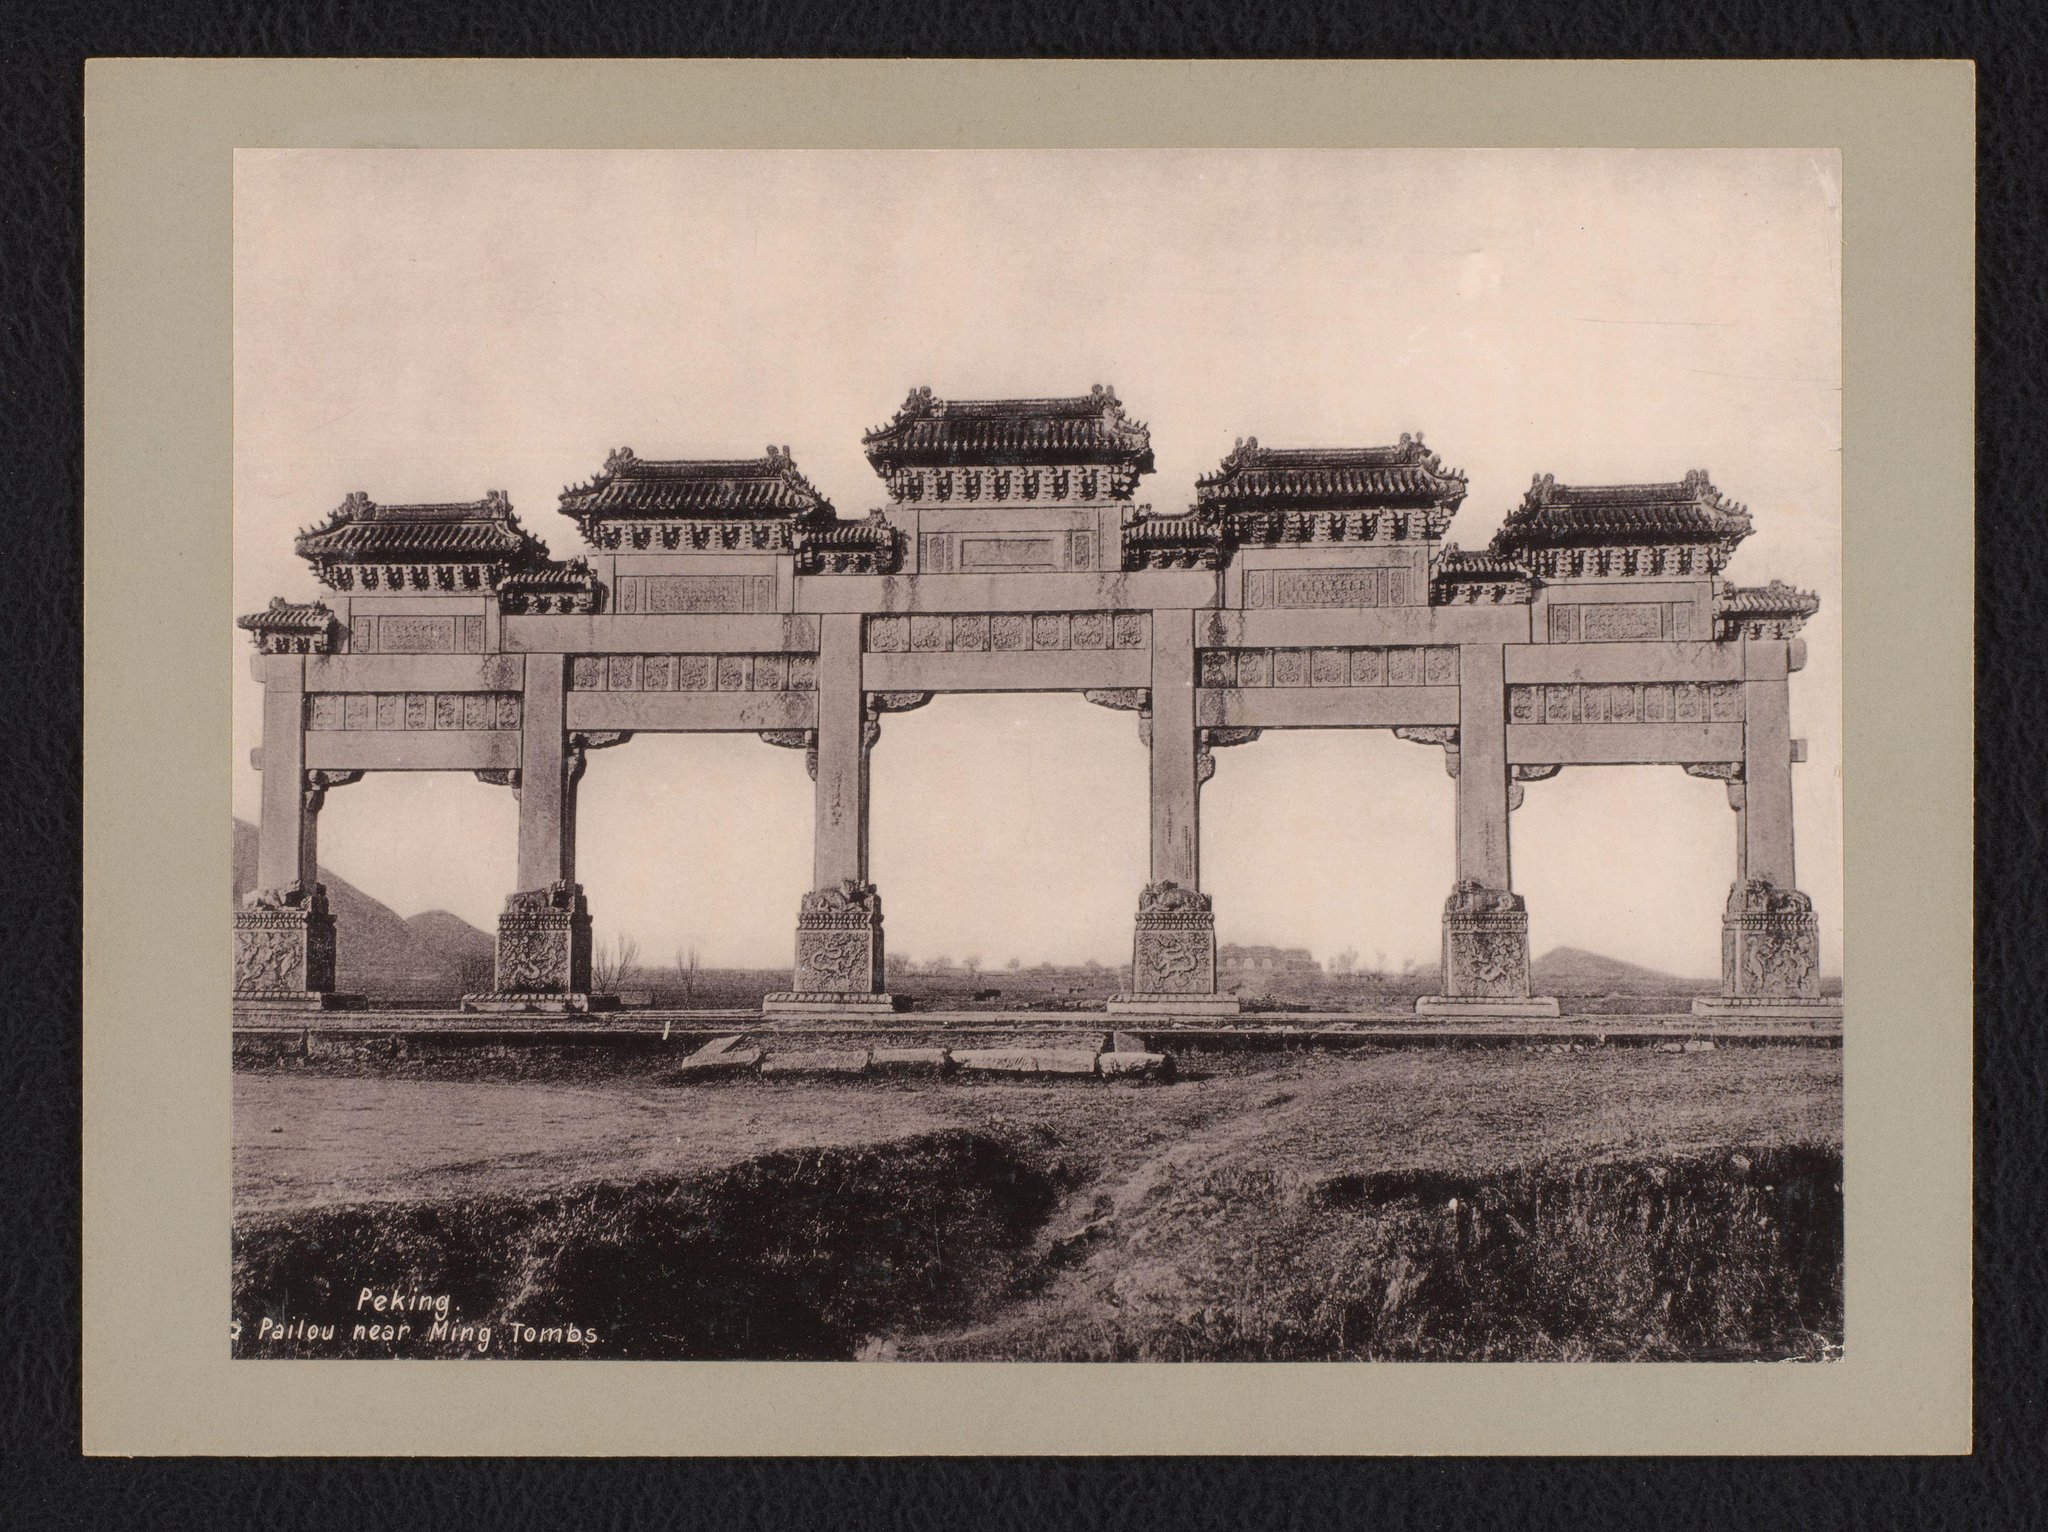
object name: photograph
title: Sierpoort nabij Ming graftomben, Peking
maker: Anonymous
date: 1895-1915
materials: cardboard, photographic support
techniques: photograph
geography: beijing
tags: peking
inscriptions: number: ‘15.’